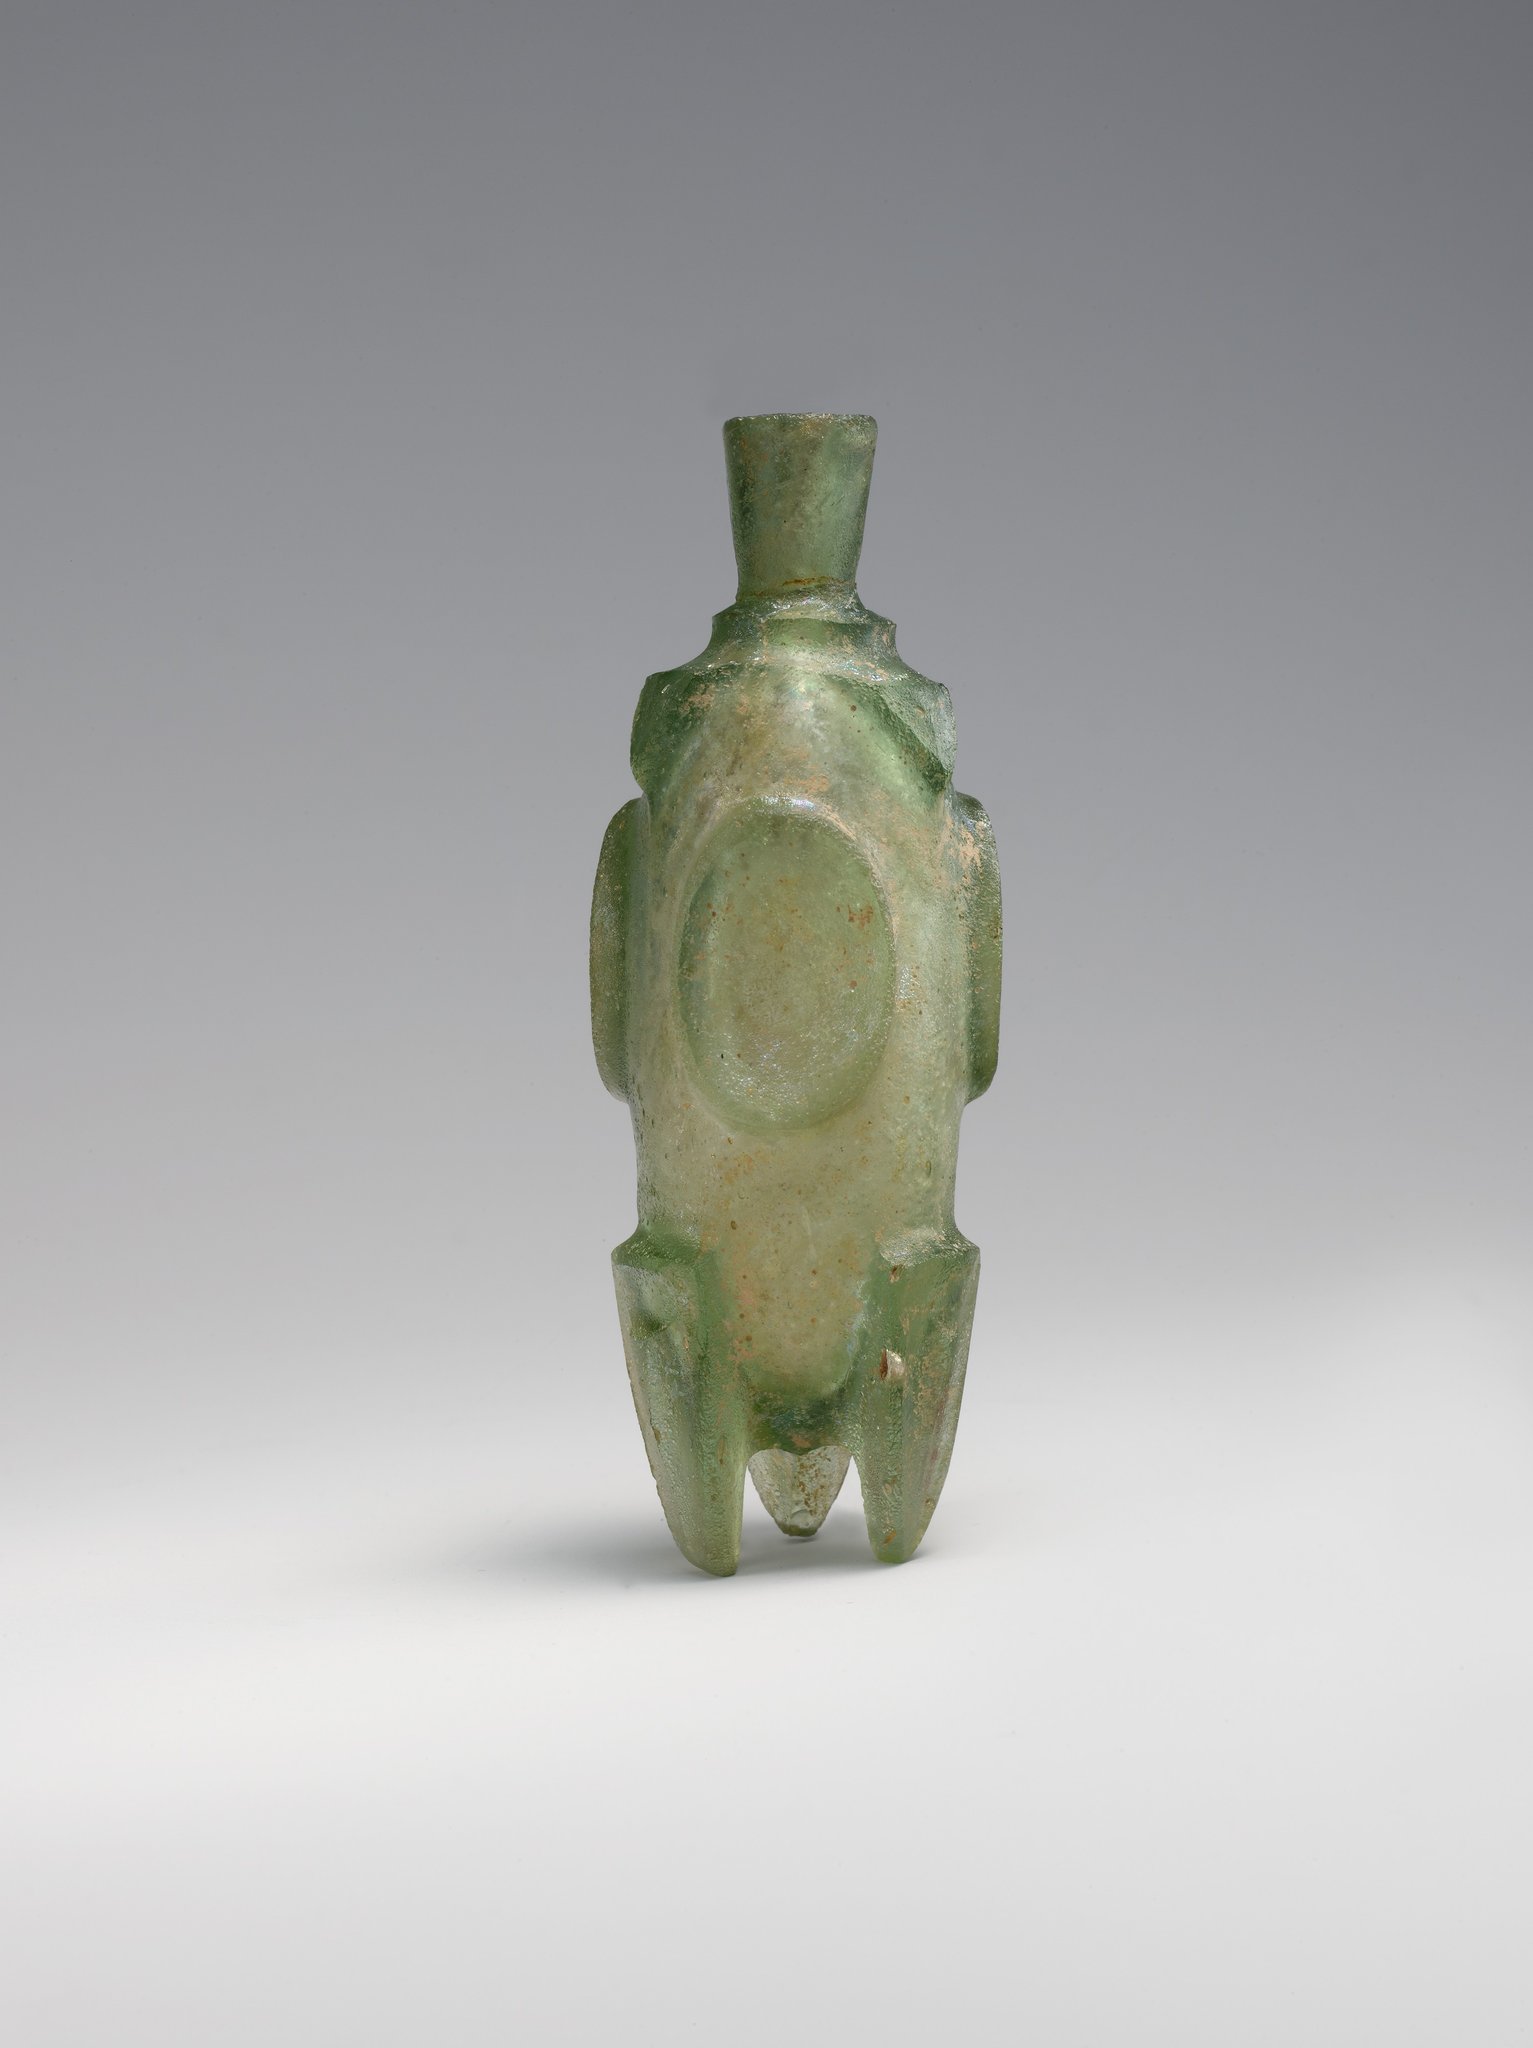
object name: bottle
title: 'Molar' flask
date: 701-900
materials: glass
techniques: glassblowing, casting, cutting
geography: iran